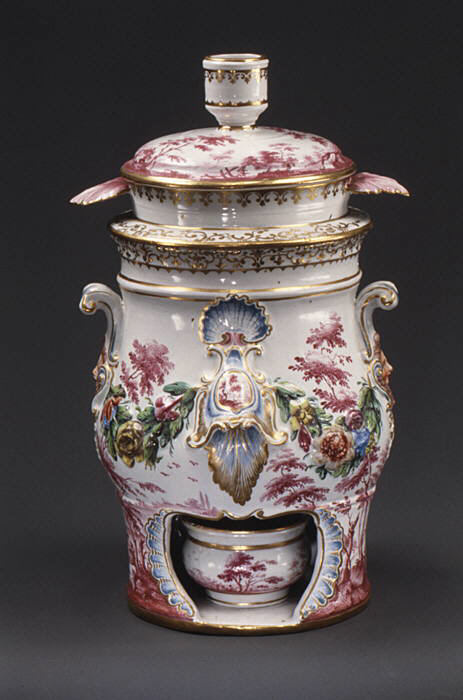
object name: food warmer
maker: doccia porcelain manufactory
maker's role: manufactory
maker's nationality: italian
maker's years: 1737-1896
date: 1760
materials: hard paste porcelain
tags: flowers,coat of arms